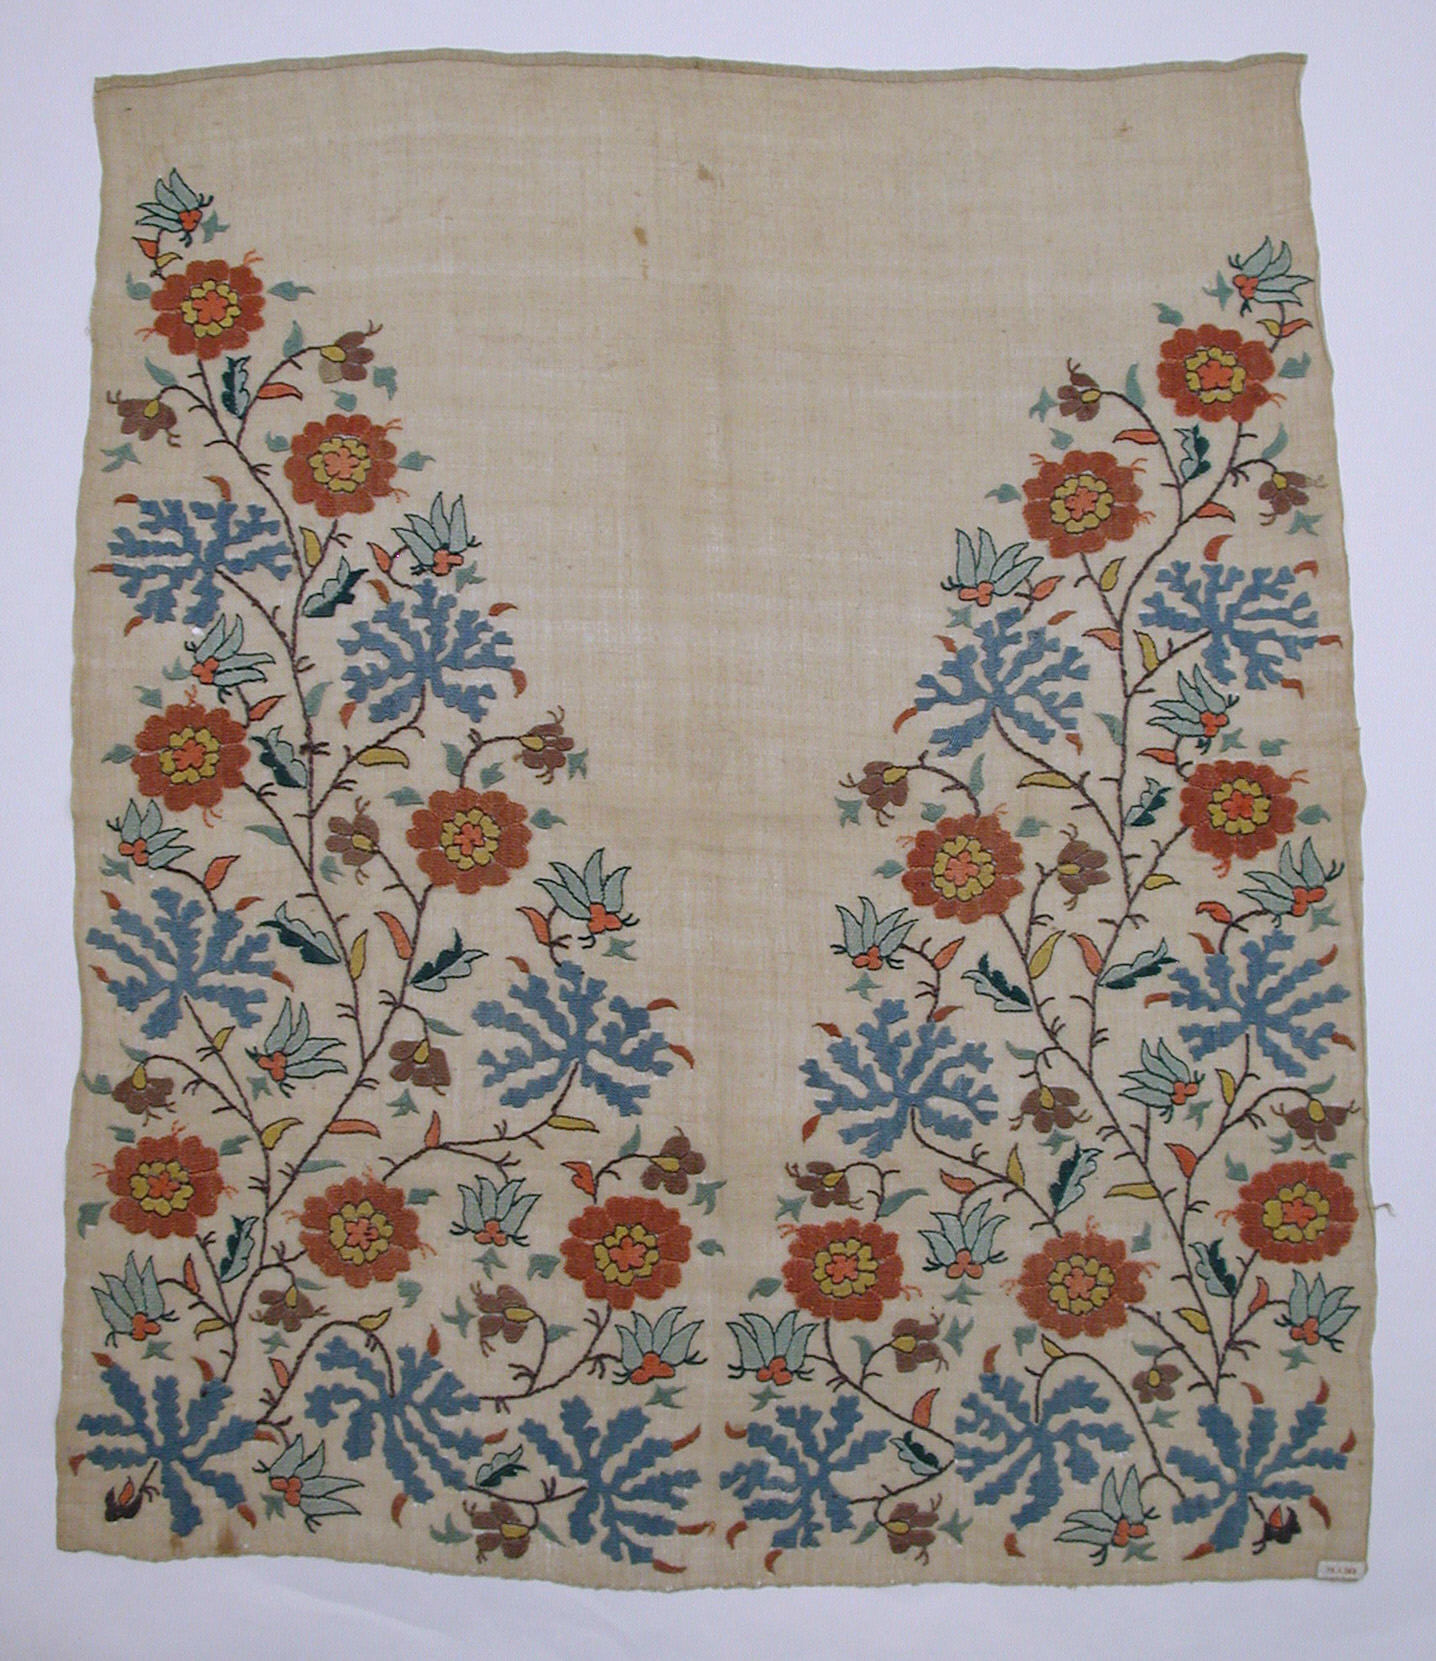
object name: towel end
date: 1801-1833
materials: linen, silk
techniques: embroidery, weave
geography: turkey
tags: flowers